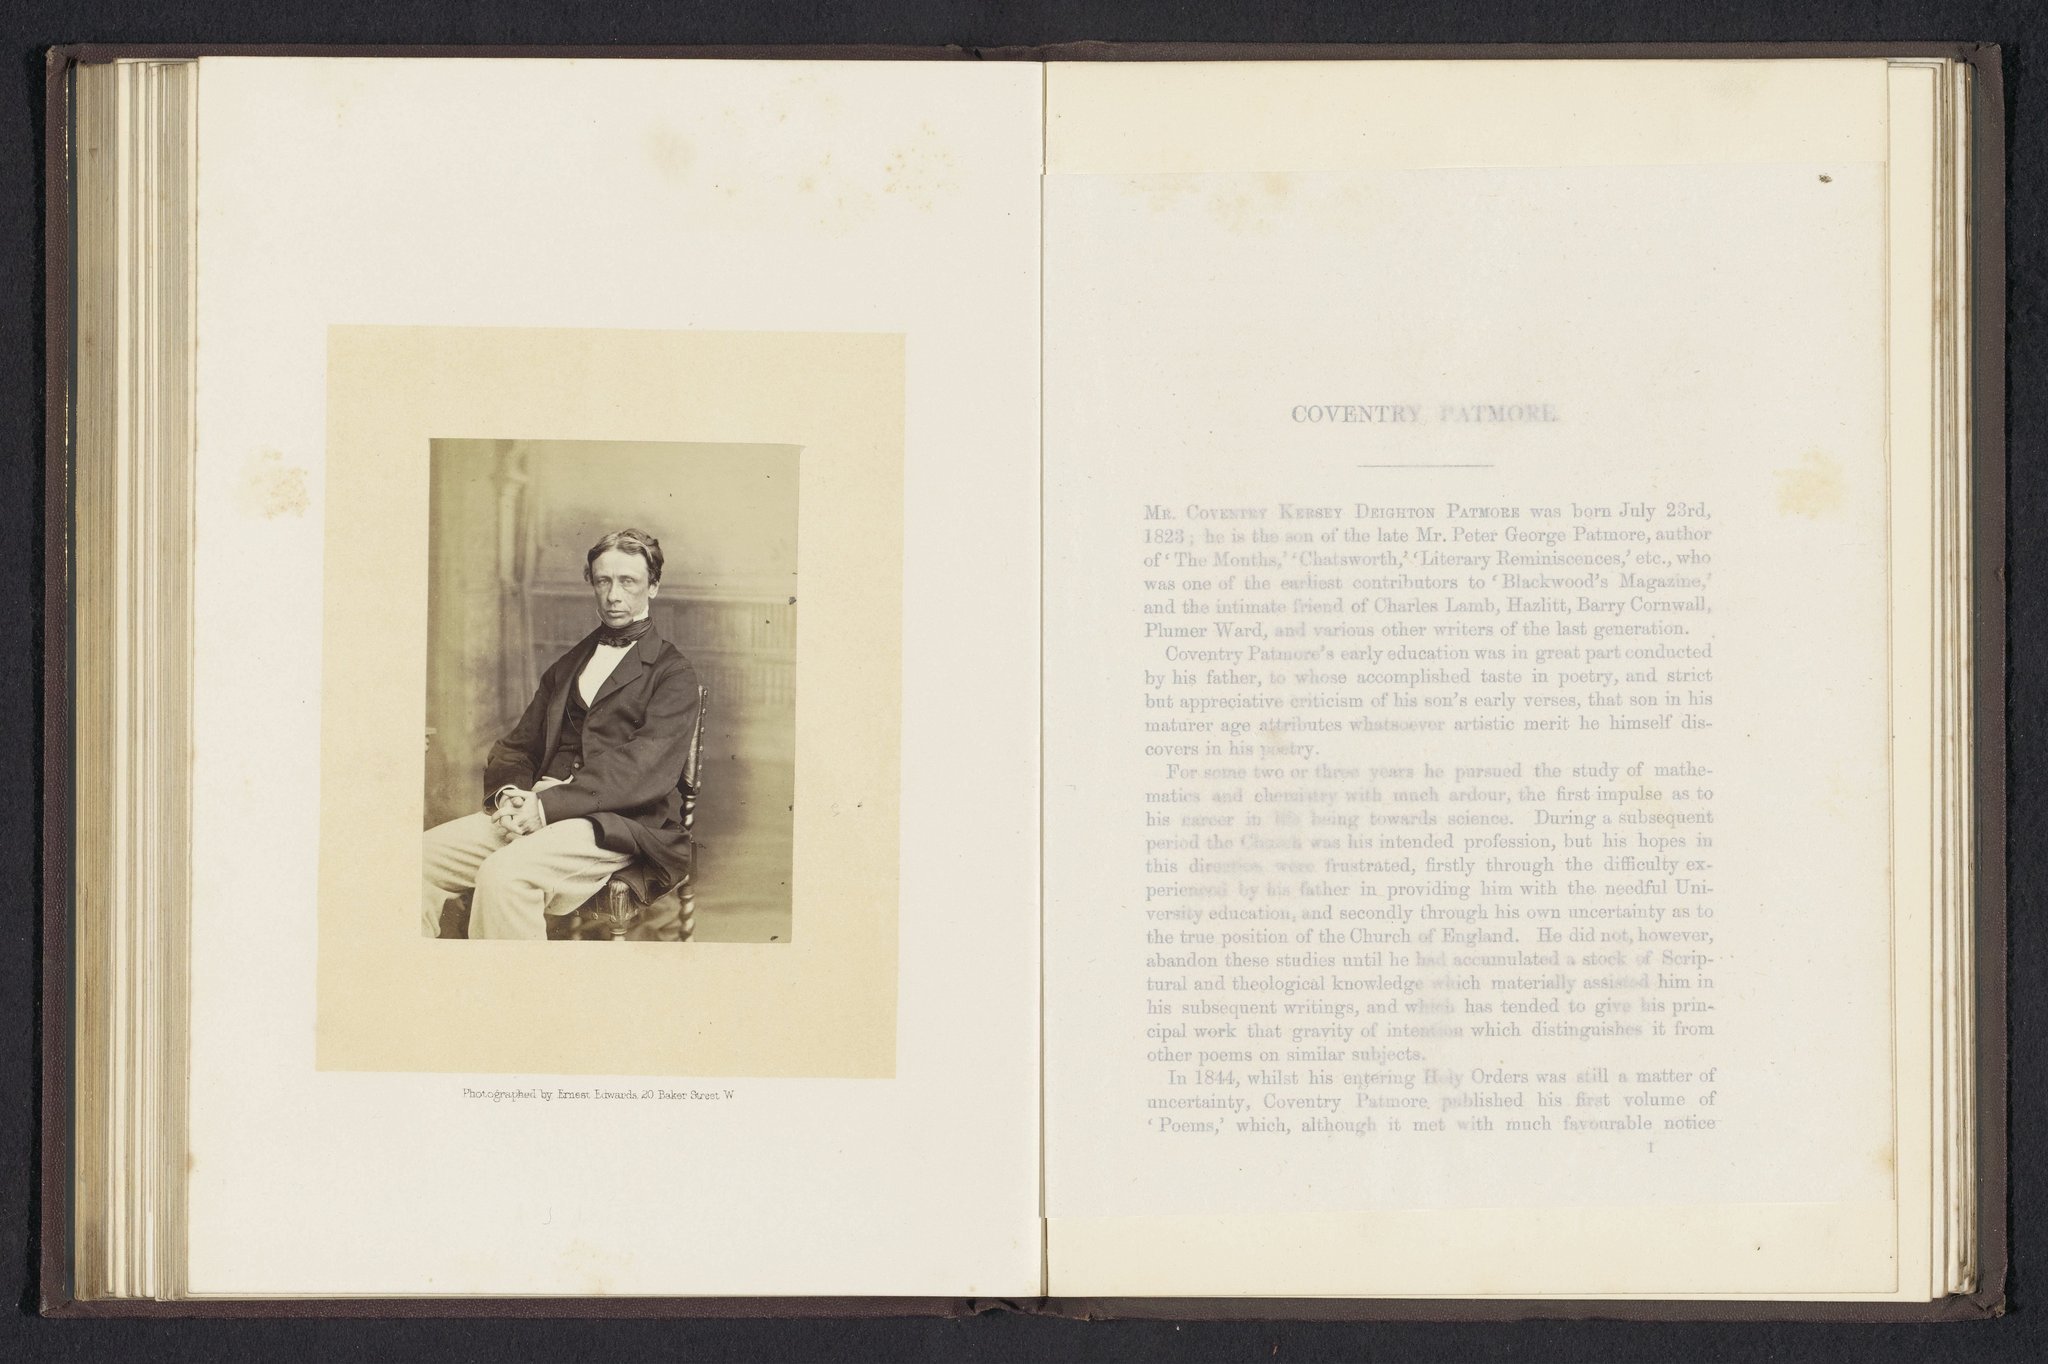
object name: photograph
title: Portret van Coventry Patmore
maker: ernest edwards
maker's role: fotograaf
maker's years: 1837-1903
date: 1858-1868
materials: paper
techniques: albumen print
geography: london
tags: historical persons, portrait of a writer